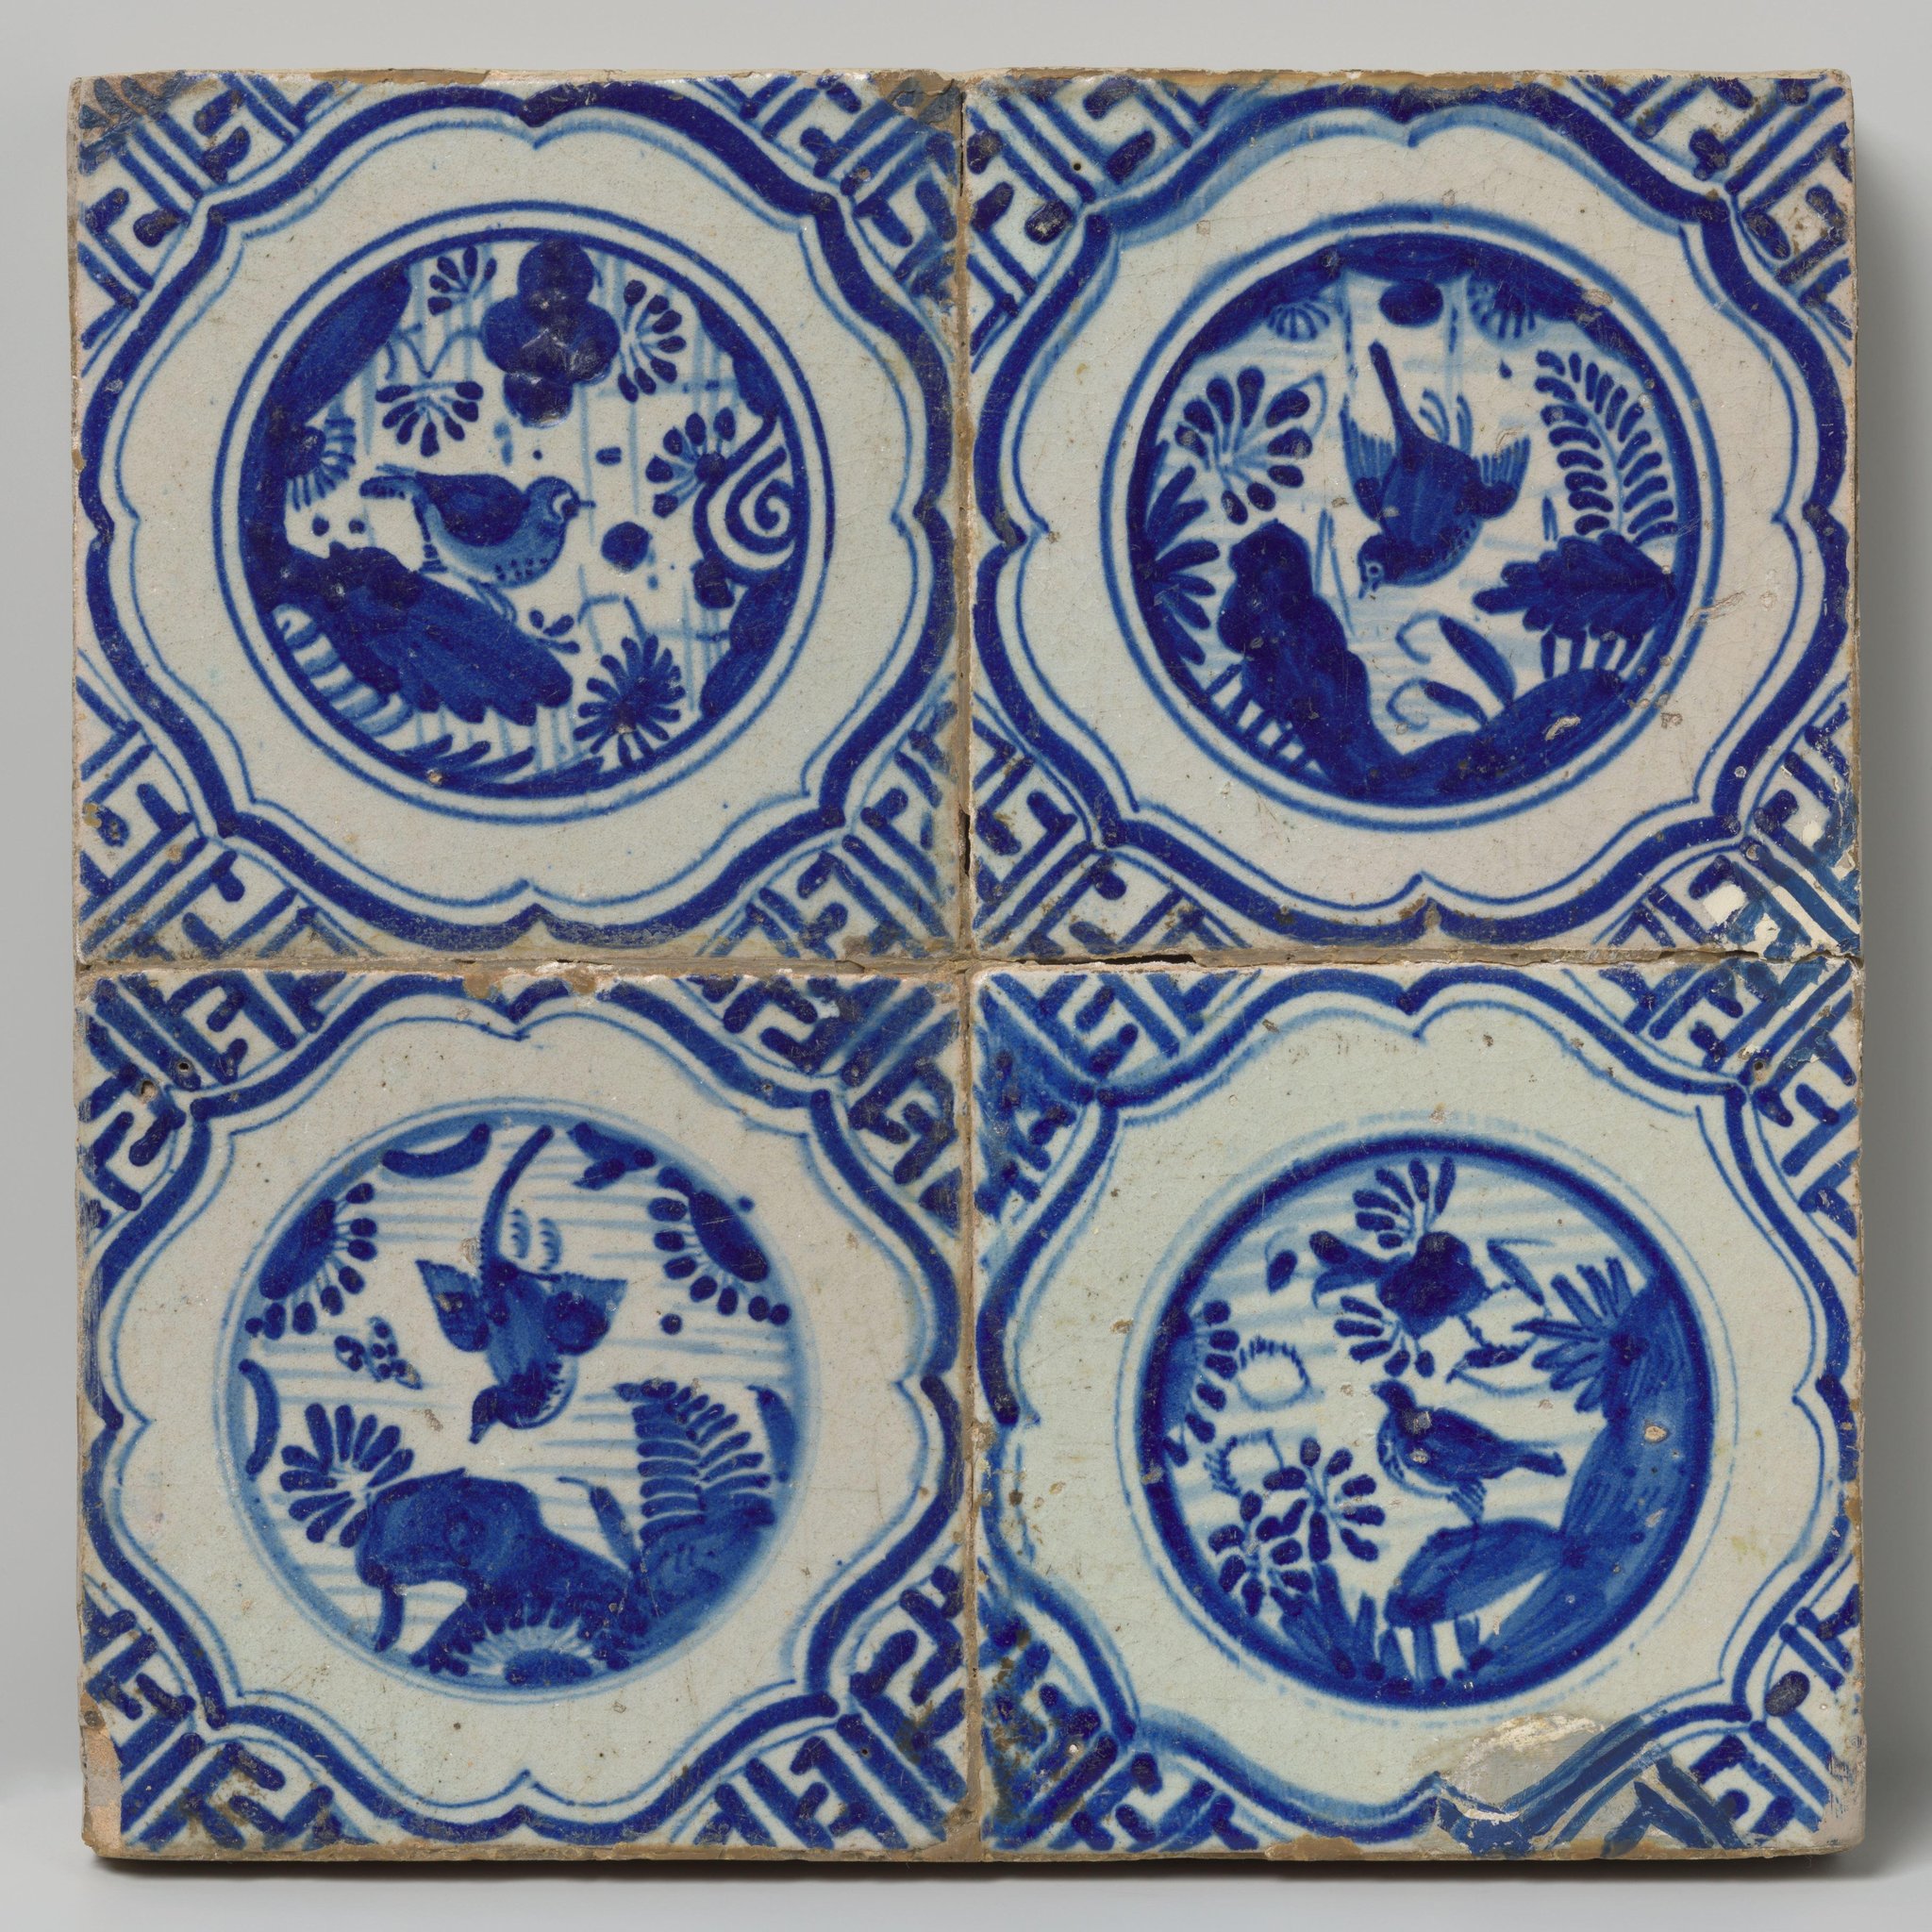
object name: tegelveld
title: Veld van vier tegels met vogels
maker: Anonymous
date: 1620-1640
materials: earthenware, glaze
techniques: maiolica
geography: netherlands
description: Veld van vier tegels (2 x 2) elk met een blauw geschilderde vogel in een Chinese tuin binnen een cirkel omgeven door een accolade. In de hoeken, meander ornament.